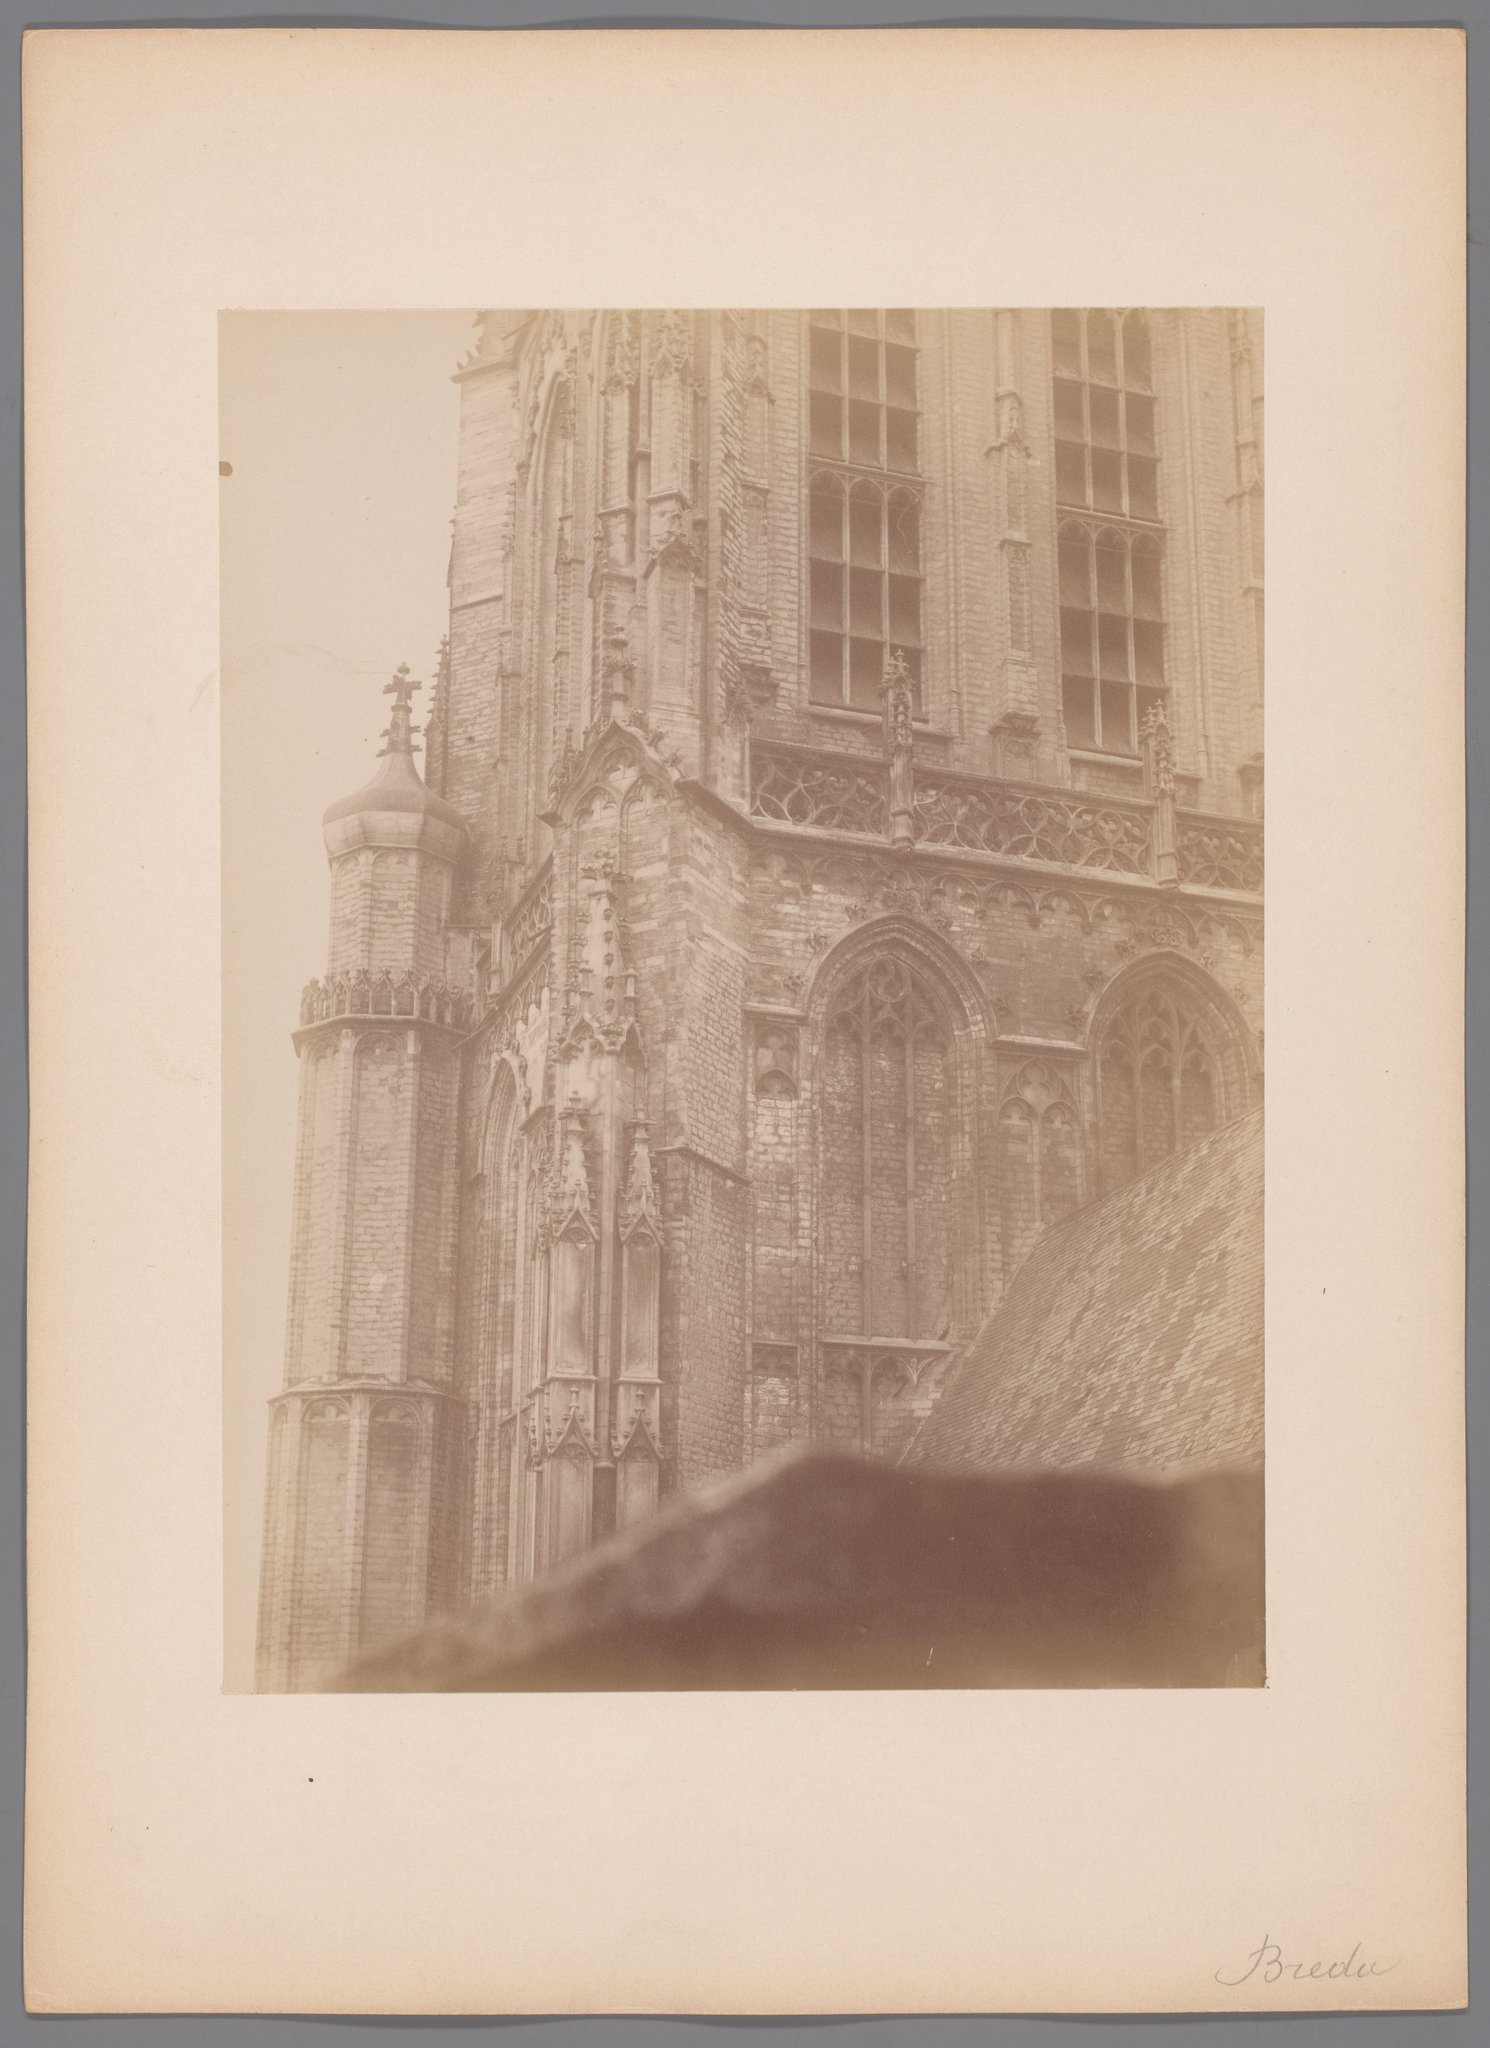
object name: photograph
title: Toren van de Grote Kerk te Breda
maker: anoniem (monumentenzorg)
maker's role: fotograaf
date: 1890-1920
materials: cardboard, photographic support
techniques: albumen print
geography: breda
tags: parts of church exterior and annexes: tower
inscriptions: annotation: ‘Gedeelte v/d toren van de Ned. Herv. Kerk te Breda’, annotation: ‘Breda’